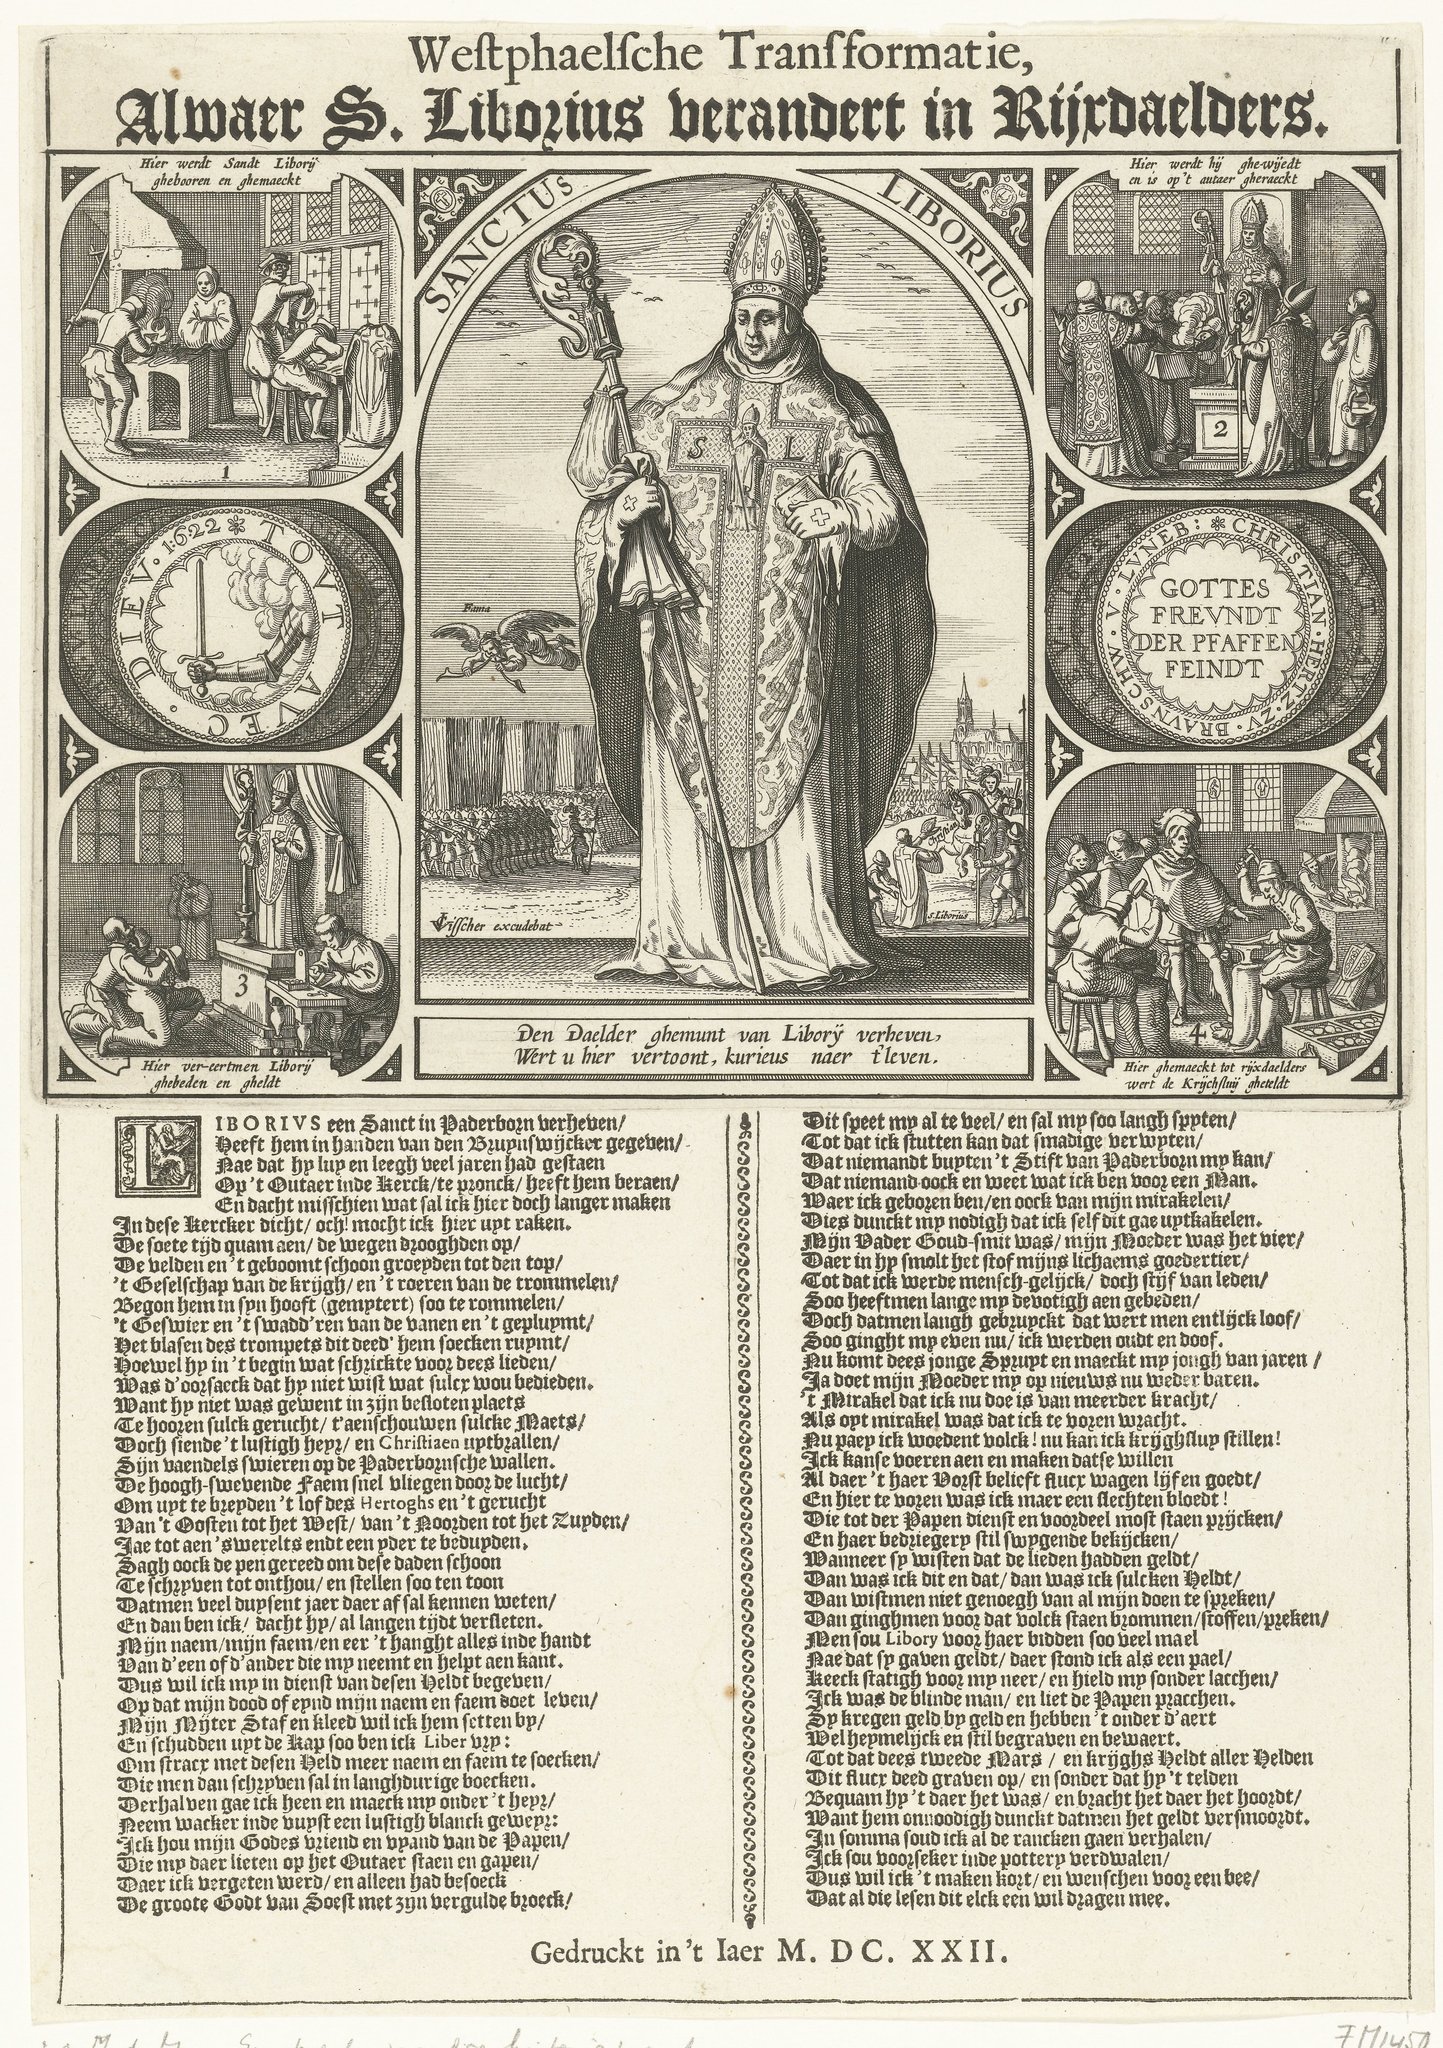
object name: print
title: Westphaelsche Transformatie, Alwaer S. Liborius verandert in Rijxdaelders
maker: claes jansz. visscher (ii)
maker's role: draughtsman, print maker, publisher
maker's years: 1586-1652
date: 1622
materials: paper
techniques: etching, letterpress printing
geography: amsterdam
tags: preparing of material by melting, male saints (with name)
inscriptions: date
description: Christiaan hertog van Brunswijk (ritmeester in Staatse dienst) laat het zilveren beeld van de heilige Liborius afkomstig uit een kerk te Munster omsmelten tot rijksdaalders om zijn soldaten te kunnen betalen, 1622. Centraal het beeld van heilige, hieromheen in vier scènes de vervaardiging van het beeld, de wijding, het aanbidden en tenslotte het omsmelten tot geldstukken. Hiertussen afbeeldingen van de voor- en achterzijde van een geldstuk. Onder de plaat een tekst van 2 kolommen in het Nederlands.